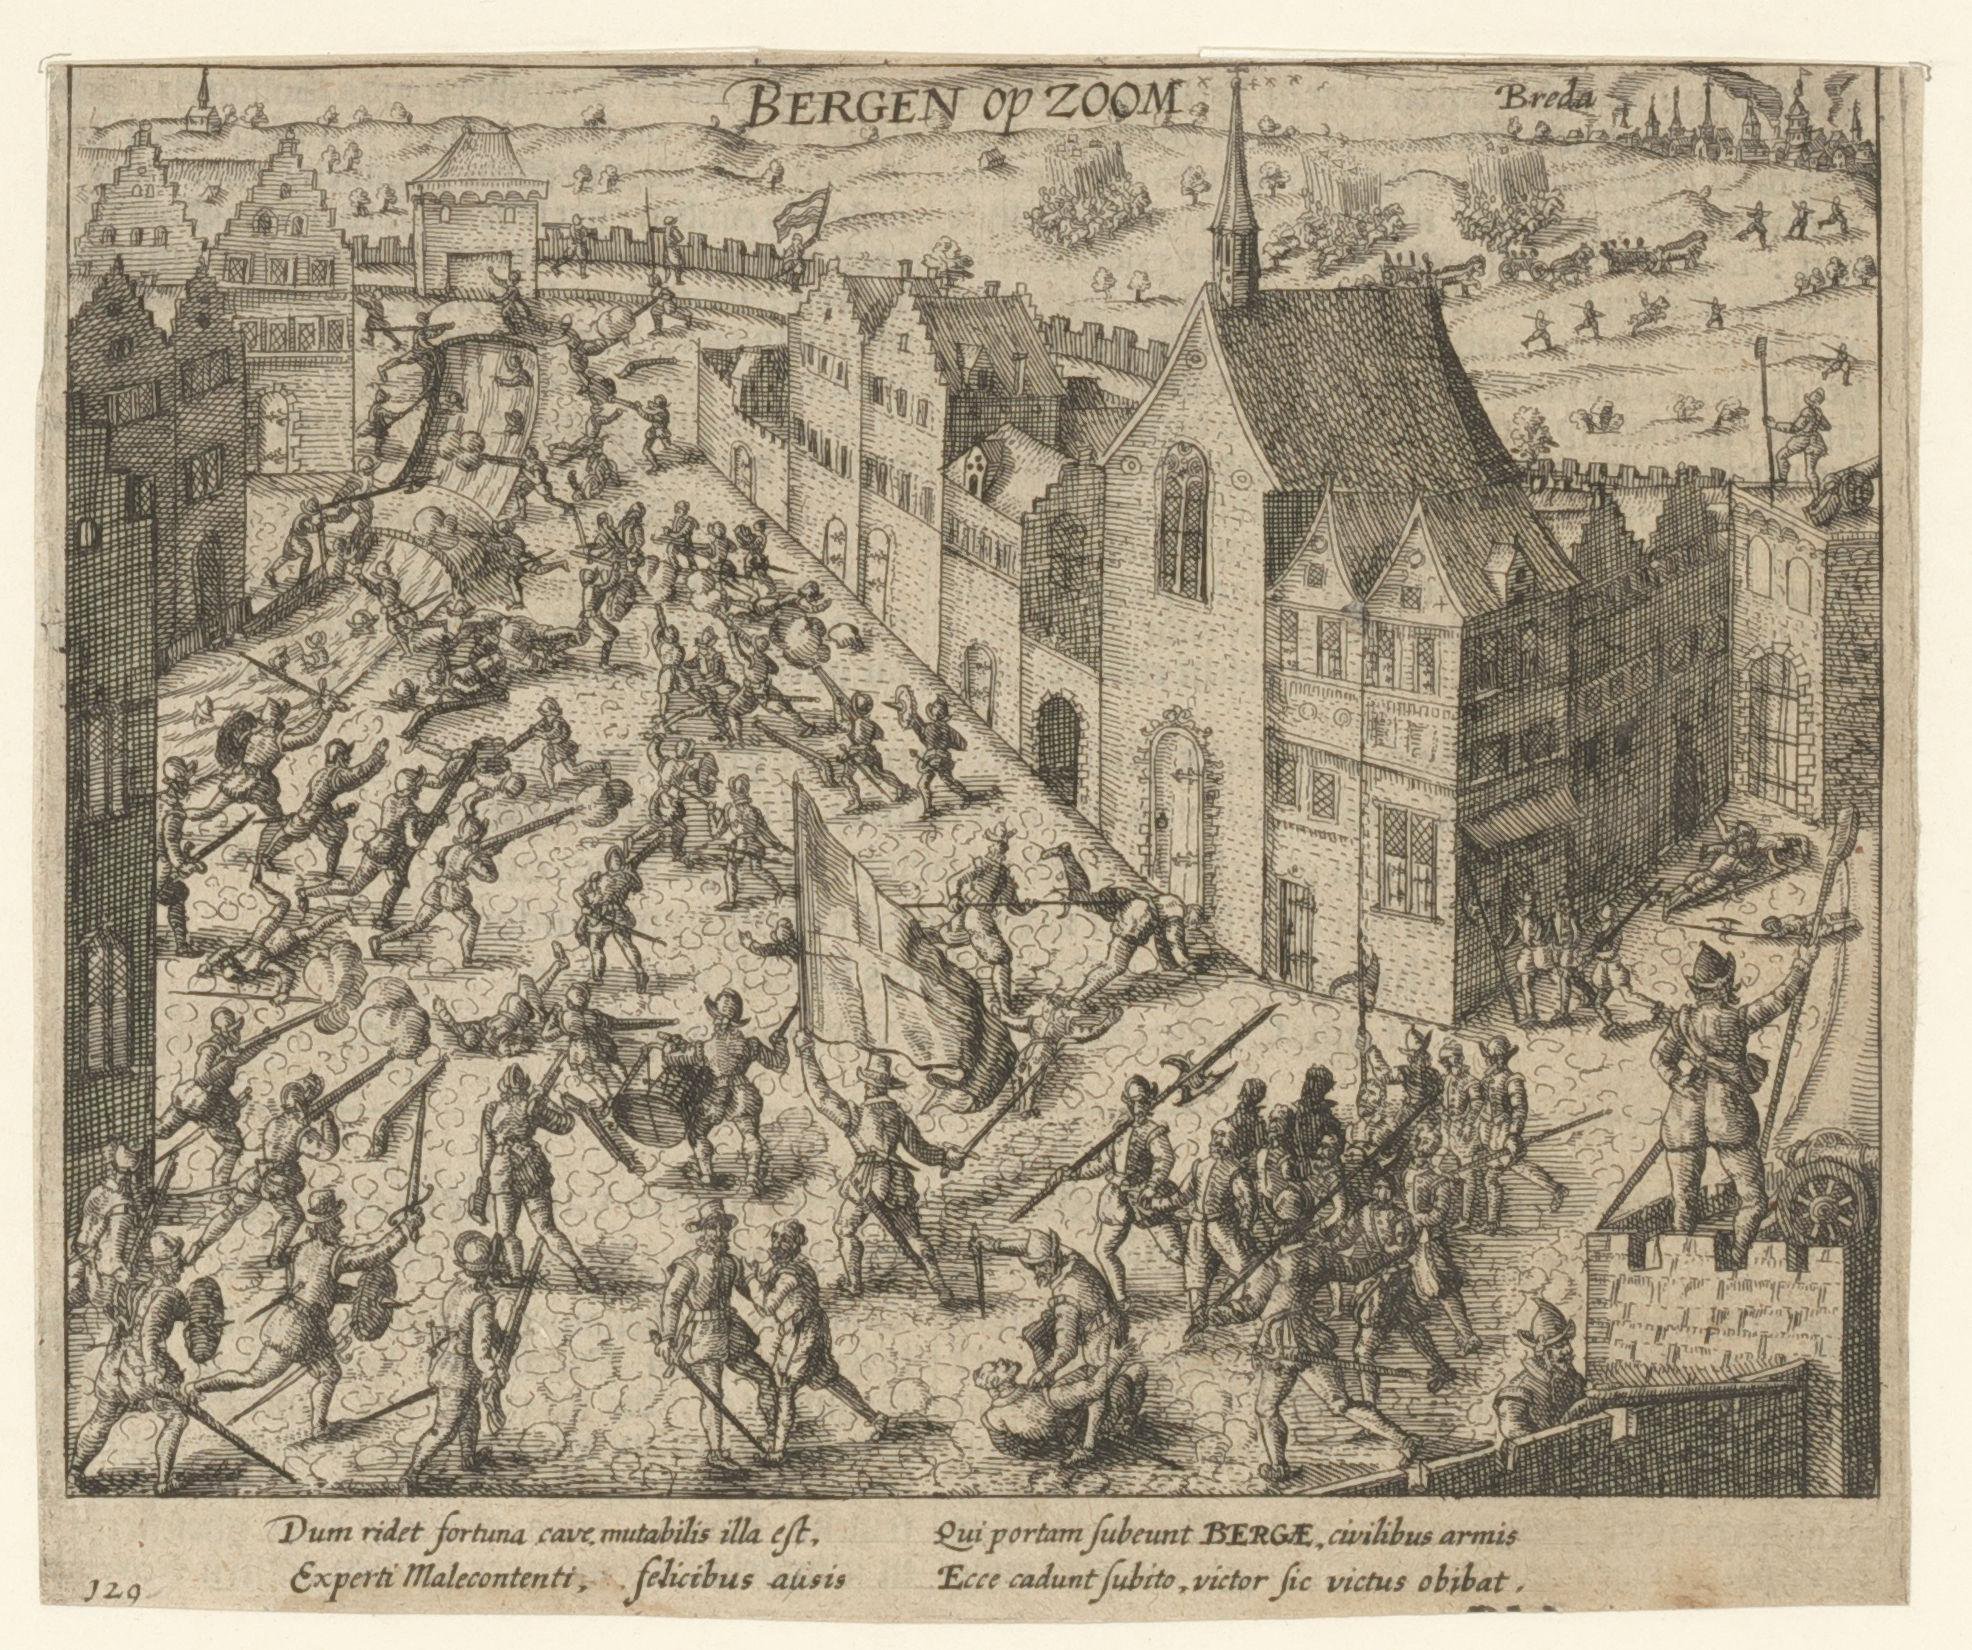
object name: history print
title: Aanslag op Bergen op Zoom verijdeld, 1581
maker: Anonymous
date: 1613-1615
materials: paper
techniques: etching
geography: northern netherlands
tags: battle, fighting in general, bergen op zoom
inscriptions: collector's mark, collector's mark: Lugt 1641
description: Aanslag op Bergen op Zoom verijdeld, 5 december 1581. De Waalse soldaten die via de Begijnenpoort de stad binnen waren gekomen in gevecht met het Franse garnizoen in de stad. Met onderschrift van 4 regels in het Latijn. Genummerd 129. Bedrukt op achterzijde met tekst in het Nederlands. Onderwerpsrubrieken binnen de Atlas Zeden en Gewoonten: Krijgswezen; prenten van Baudart. 80j. oorlog.